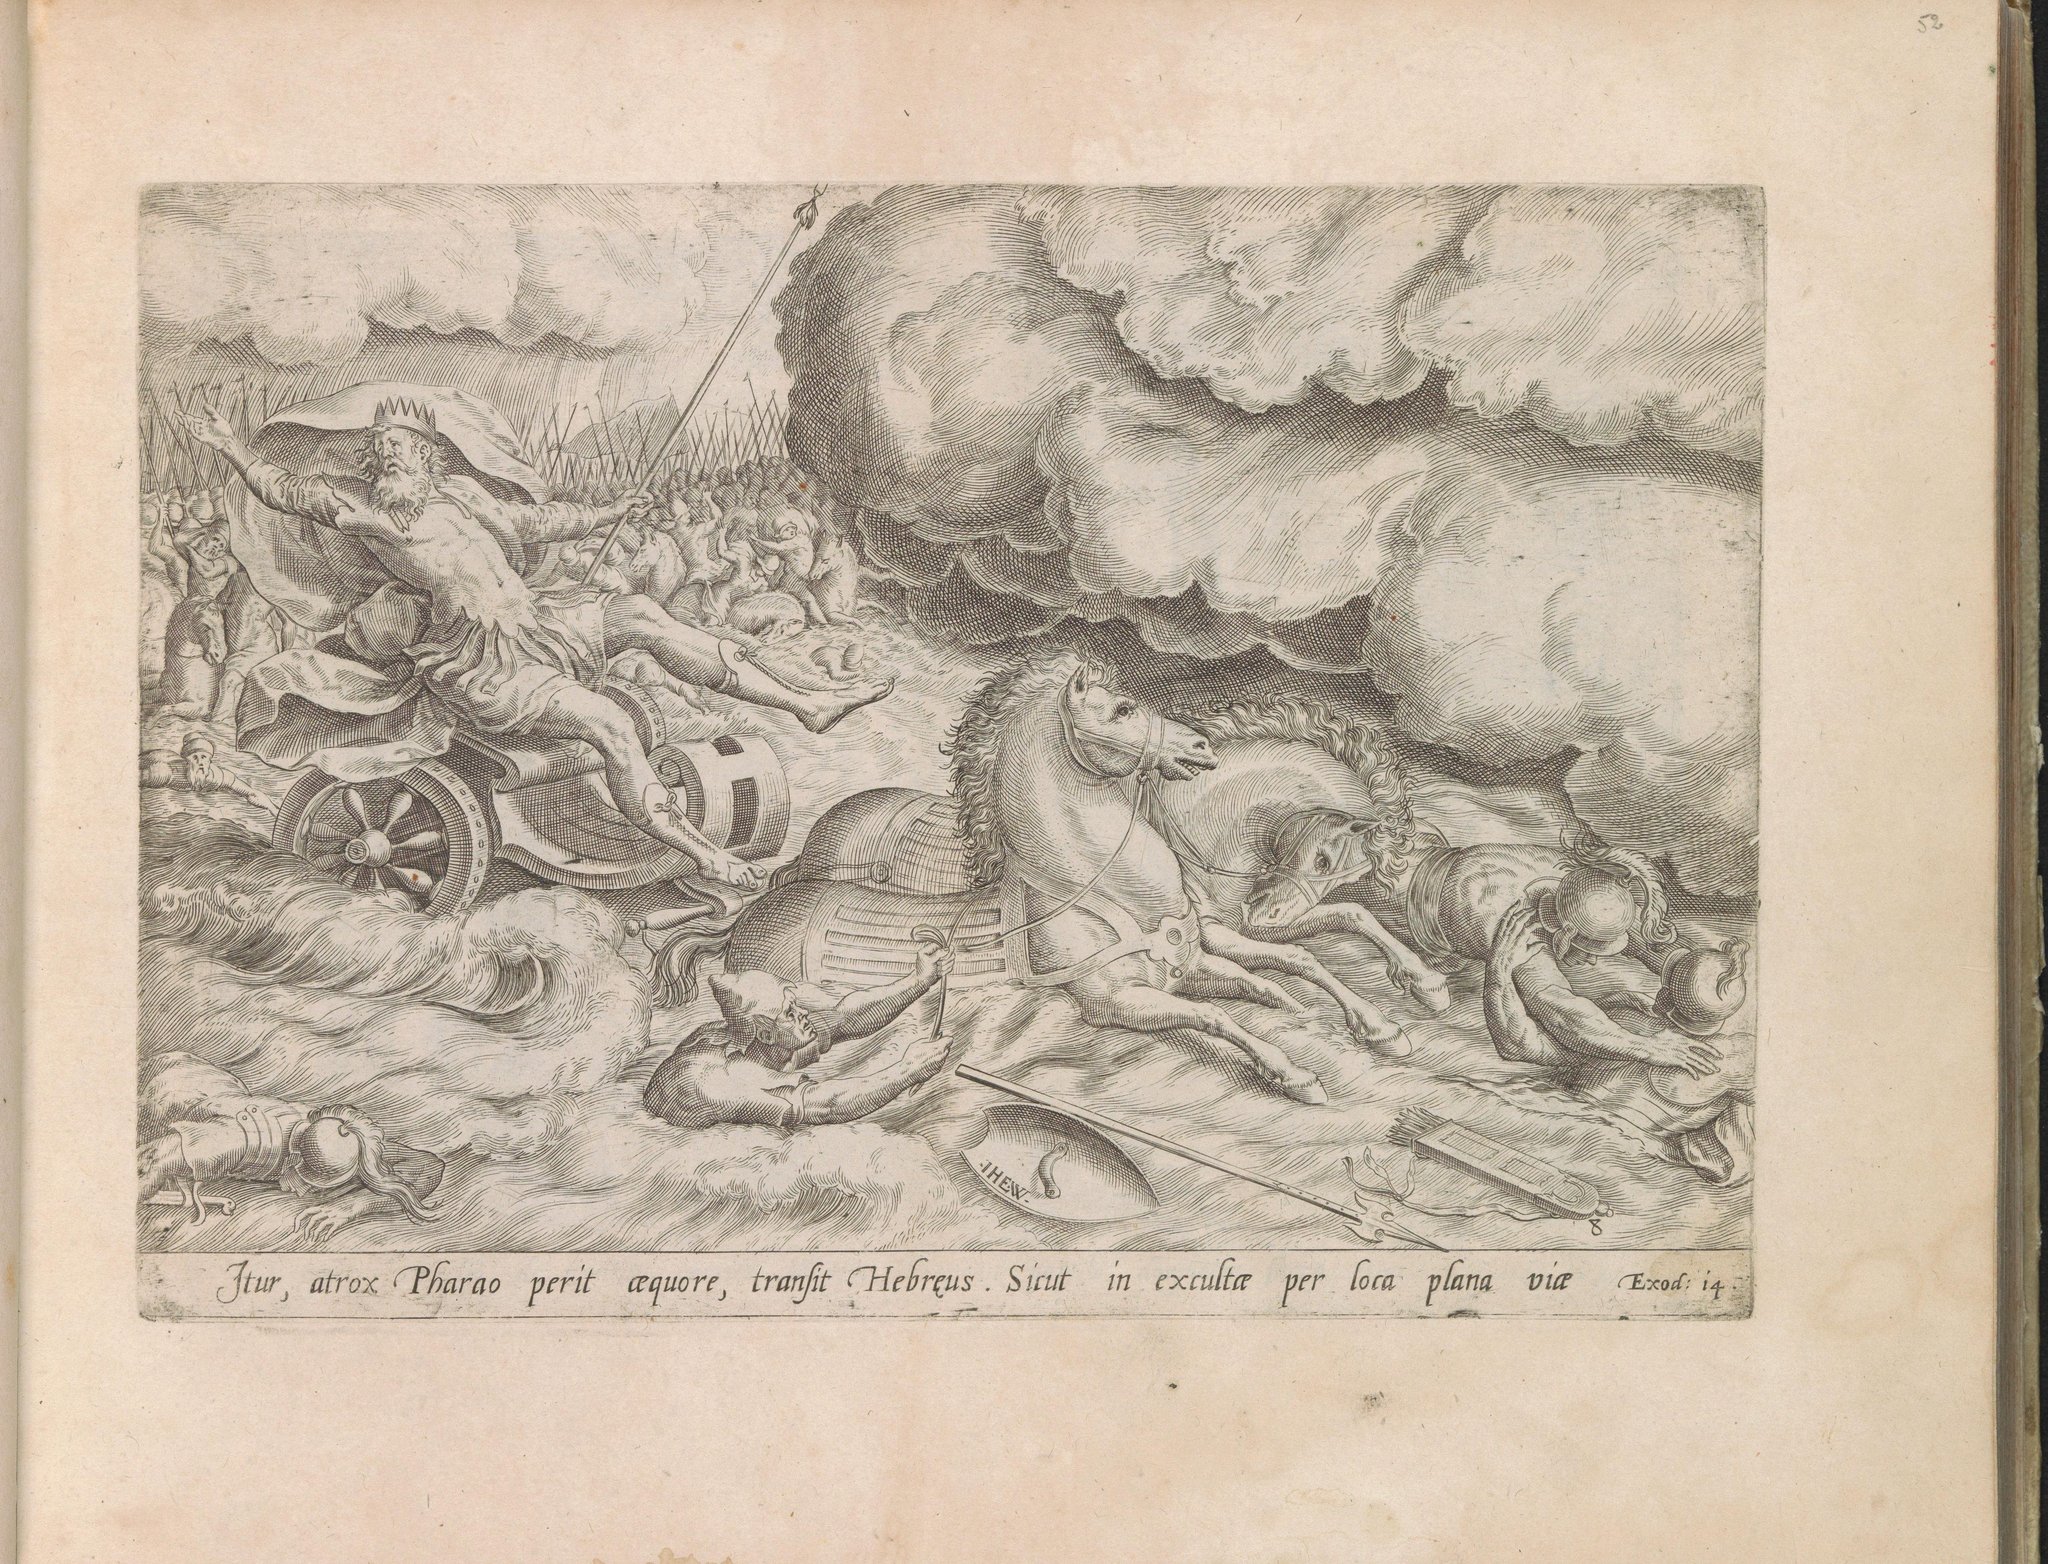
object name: album leaf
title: Vernietiging van het Egyptische leger in de Rode Zee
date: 1585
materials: paper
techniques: engraving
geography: antwerp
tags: pharaoh and his army engulfed in the red sea (israelites not or barely visible)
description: Nadat de Israëlieten de overzijde van de Rode Zee hebben bereikt, stroomt het water van de Rode Zee terug, waardoor farao en zijn leger verdrinken. Onder de voorstelling een verwijzing in het Latijn naar de Bijbeltekst in Ex. 14. Deze prent maakt deel uit van een album.